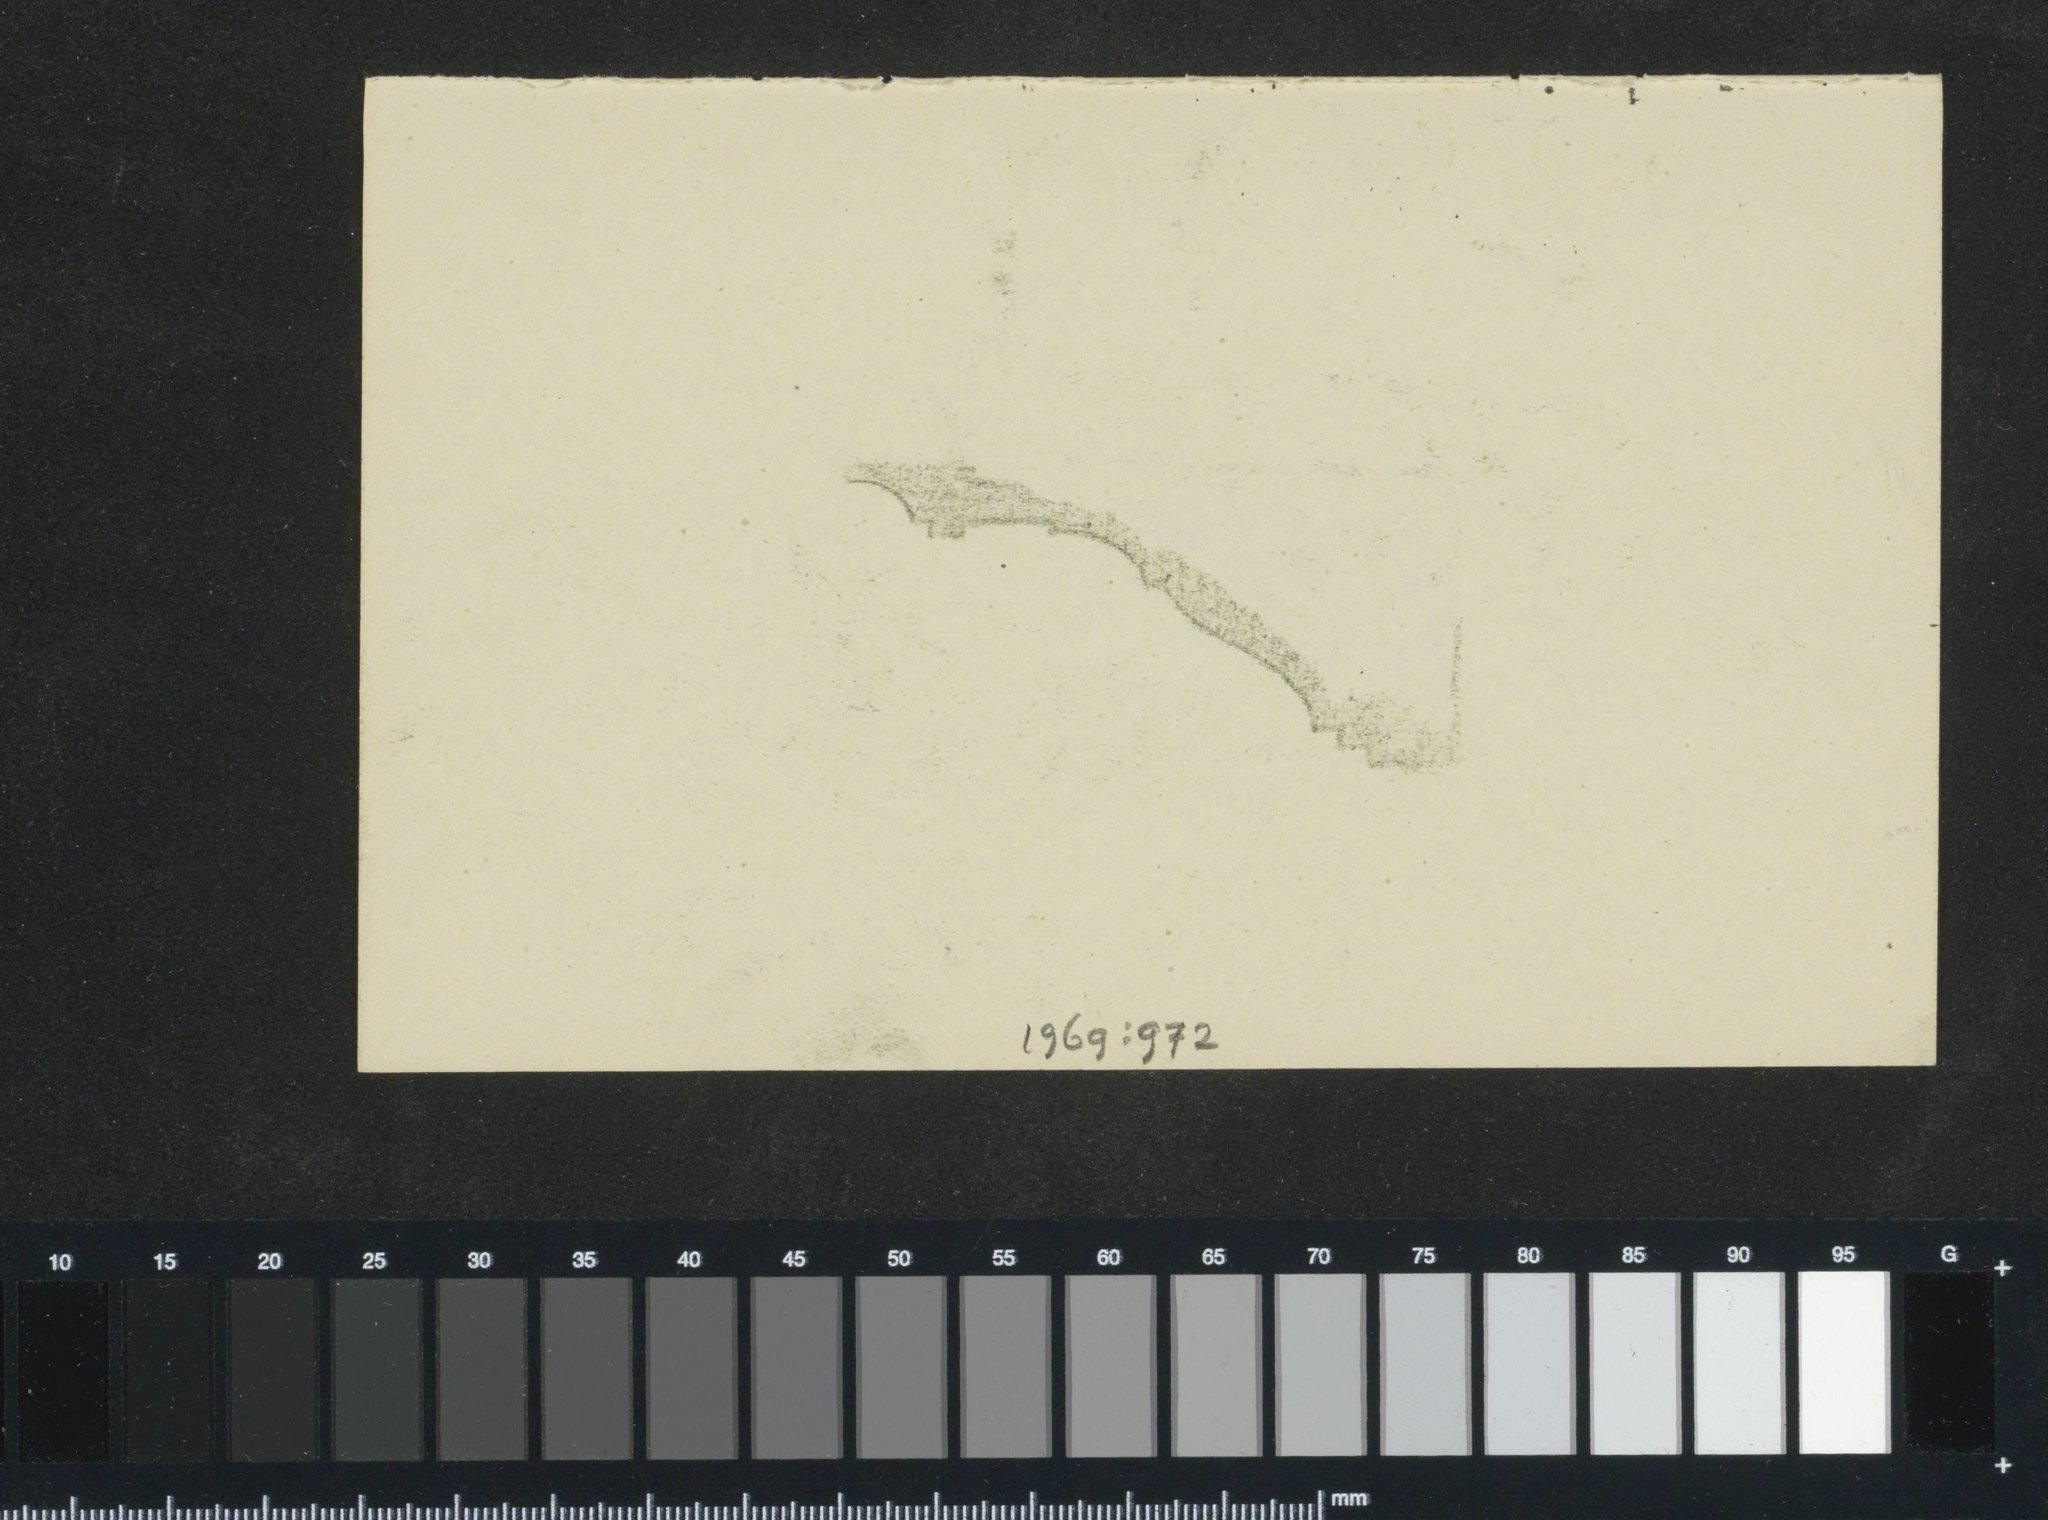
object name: drawing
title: Console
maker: gerrit willem dijsselhof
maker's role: designer, draughtsman, print maker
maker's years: 1866-1924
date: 1876-1924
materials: chalk, paper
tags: architectural detail